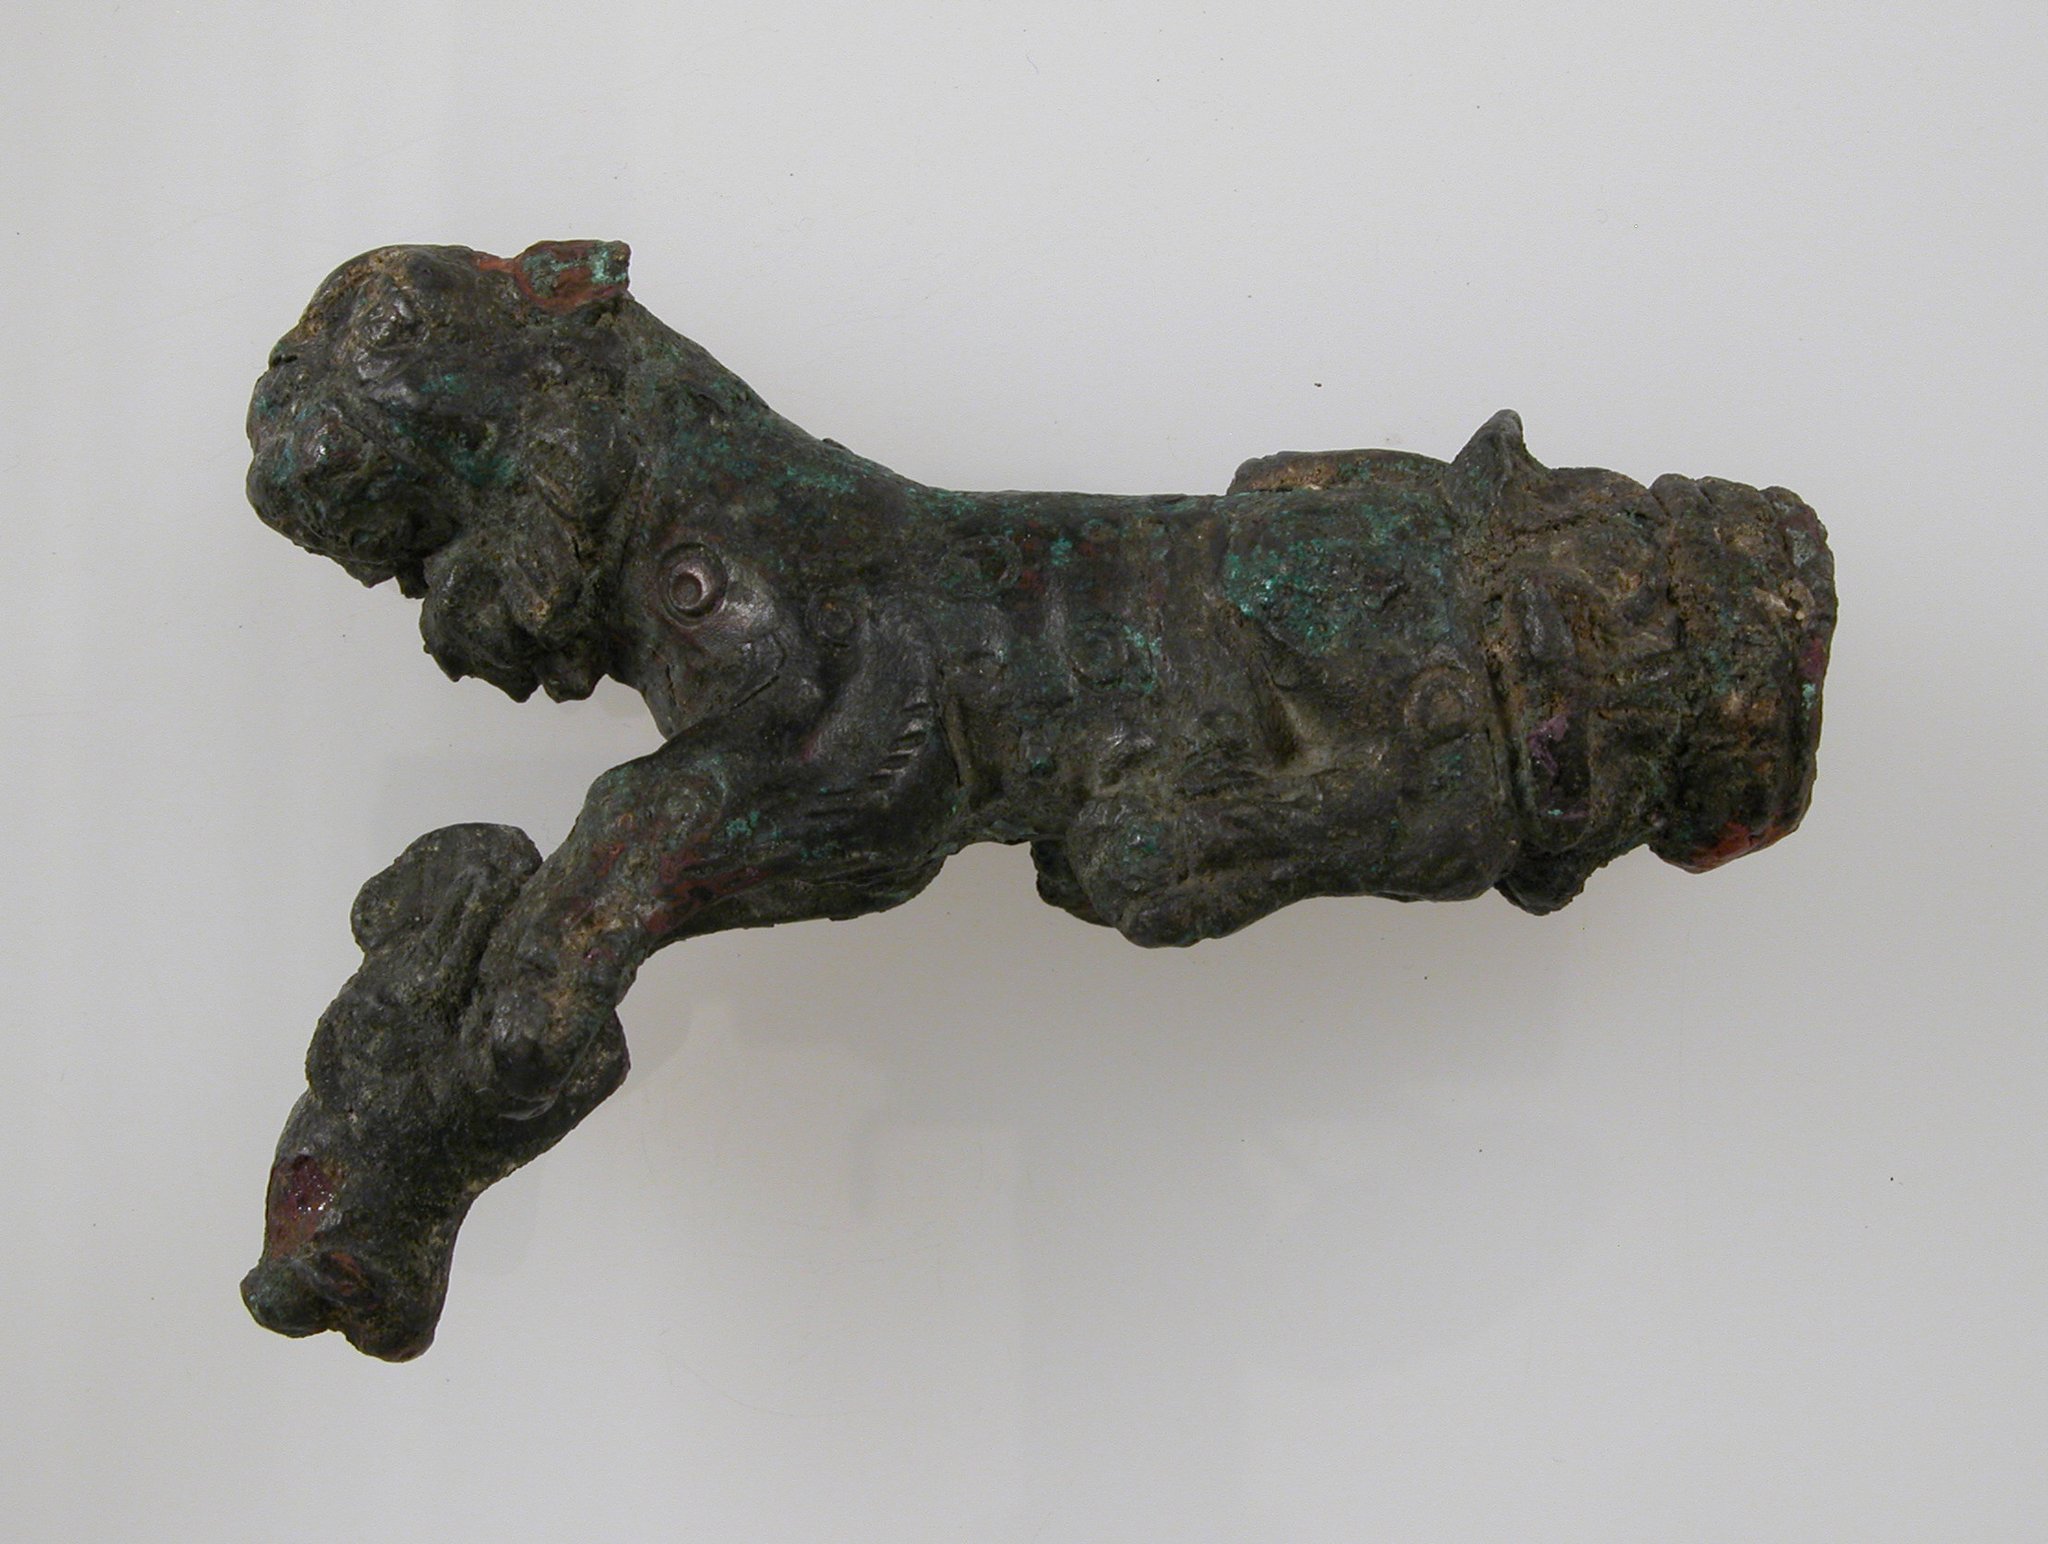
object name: key or knife handle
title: Key Handle or Knife Handle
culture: roman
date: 1-700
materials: copper alloy